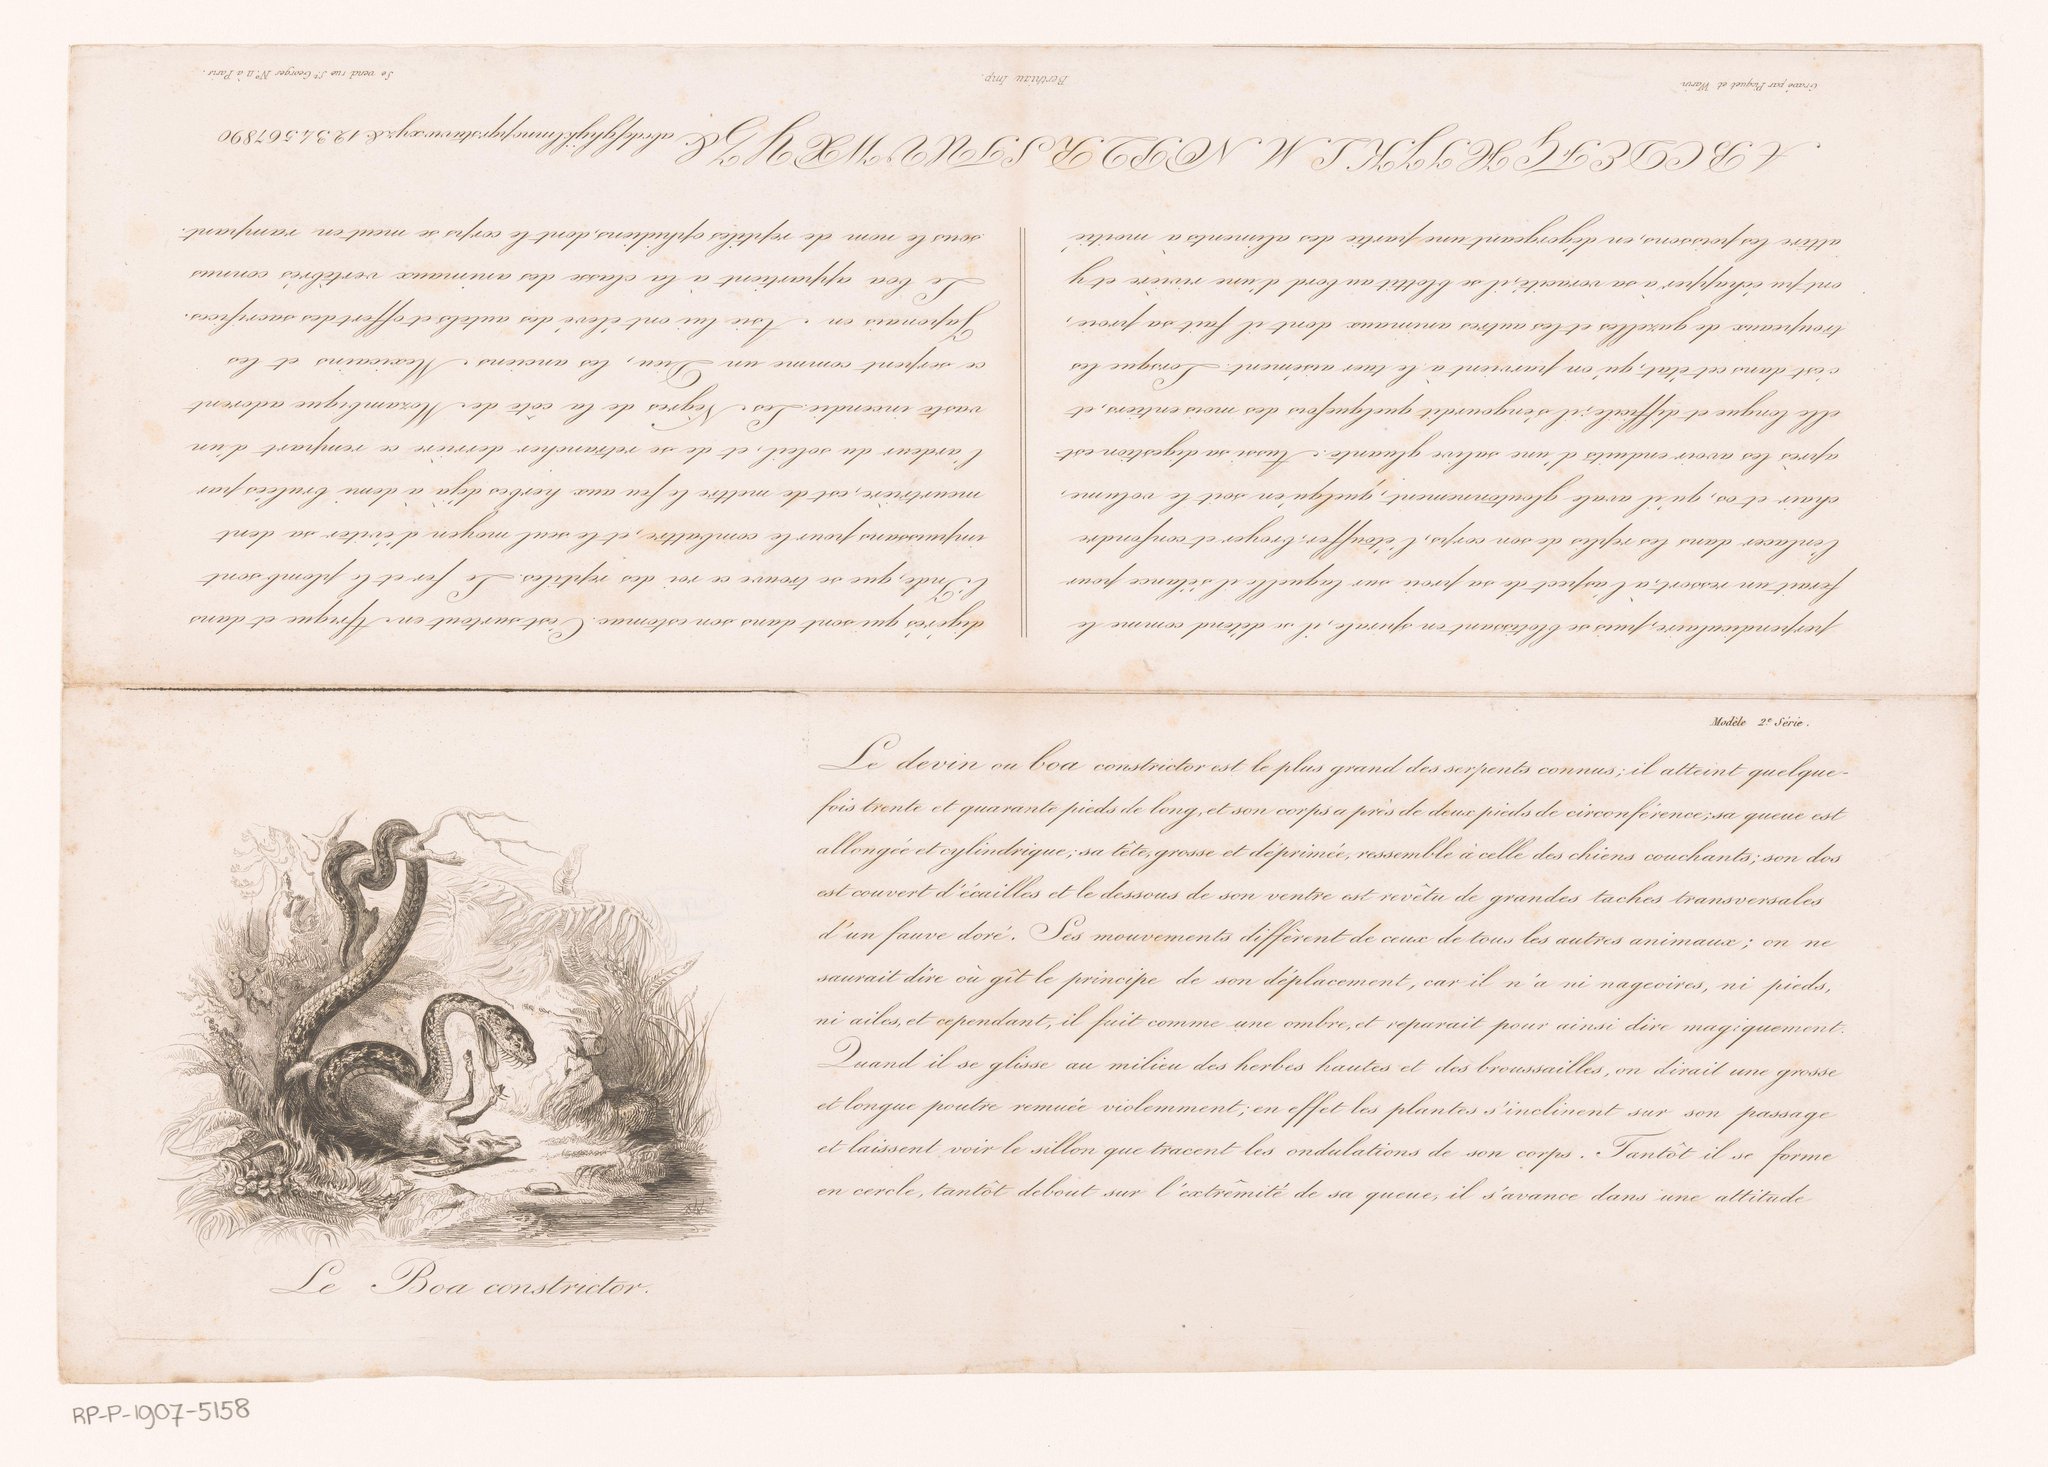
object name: print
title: Slang met prooi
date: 1800-1899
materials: paper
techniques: engraving, etching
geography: paris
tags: snakes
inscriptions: collector's mark: Lugt 2228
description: Slang gewikkeld om een bok, met beschrijvende tekst van twee kanten te lezen.